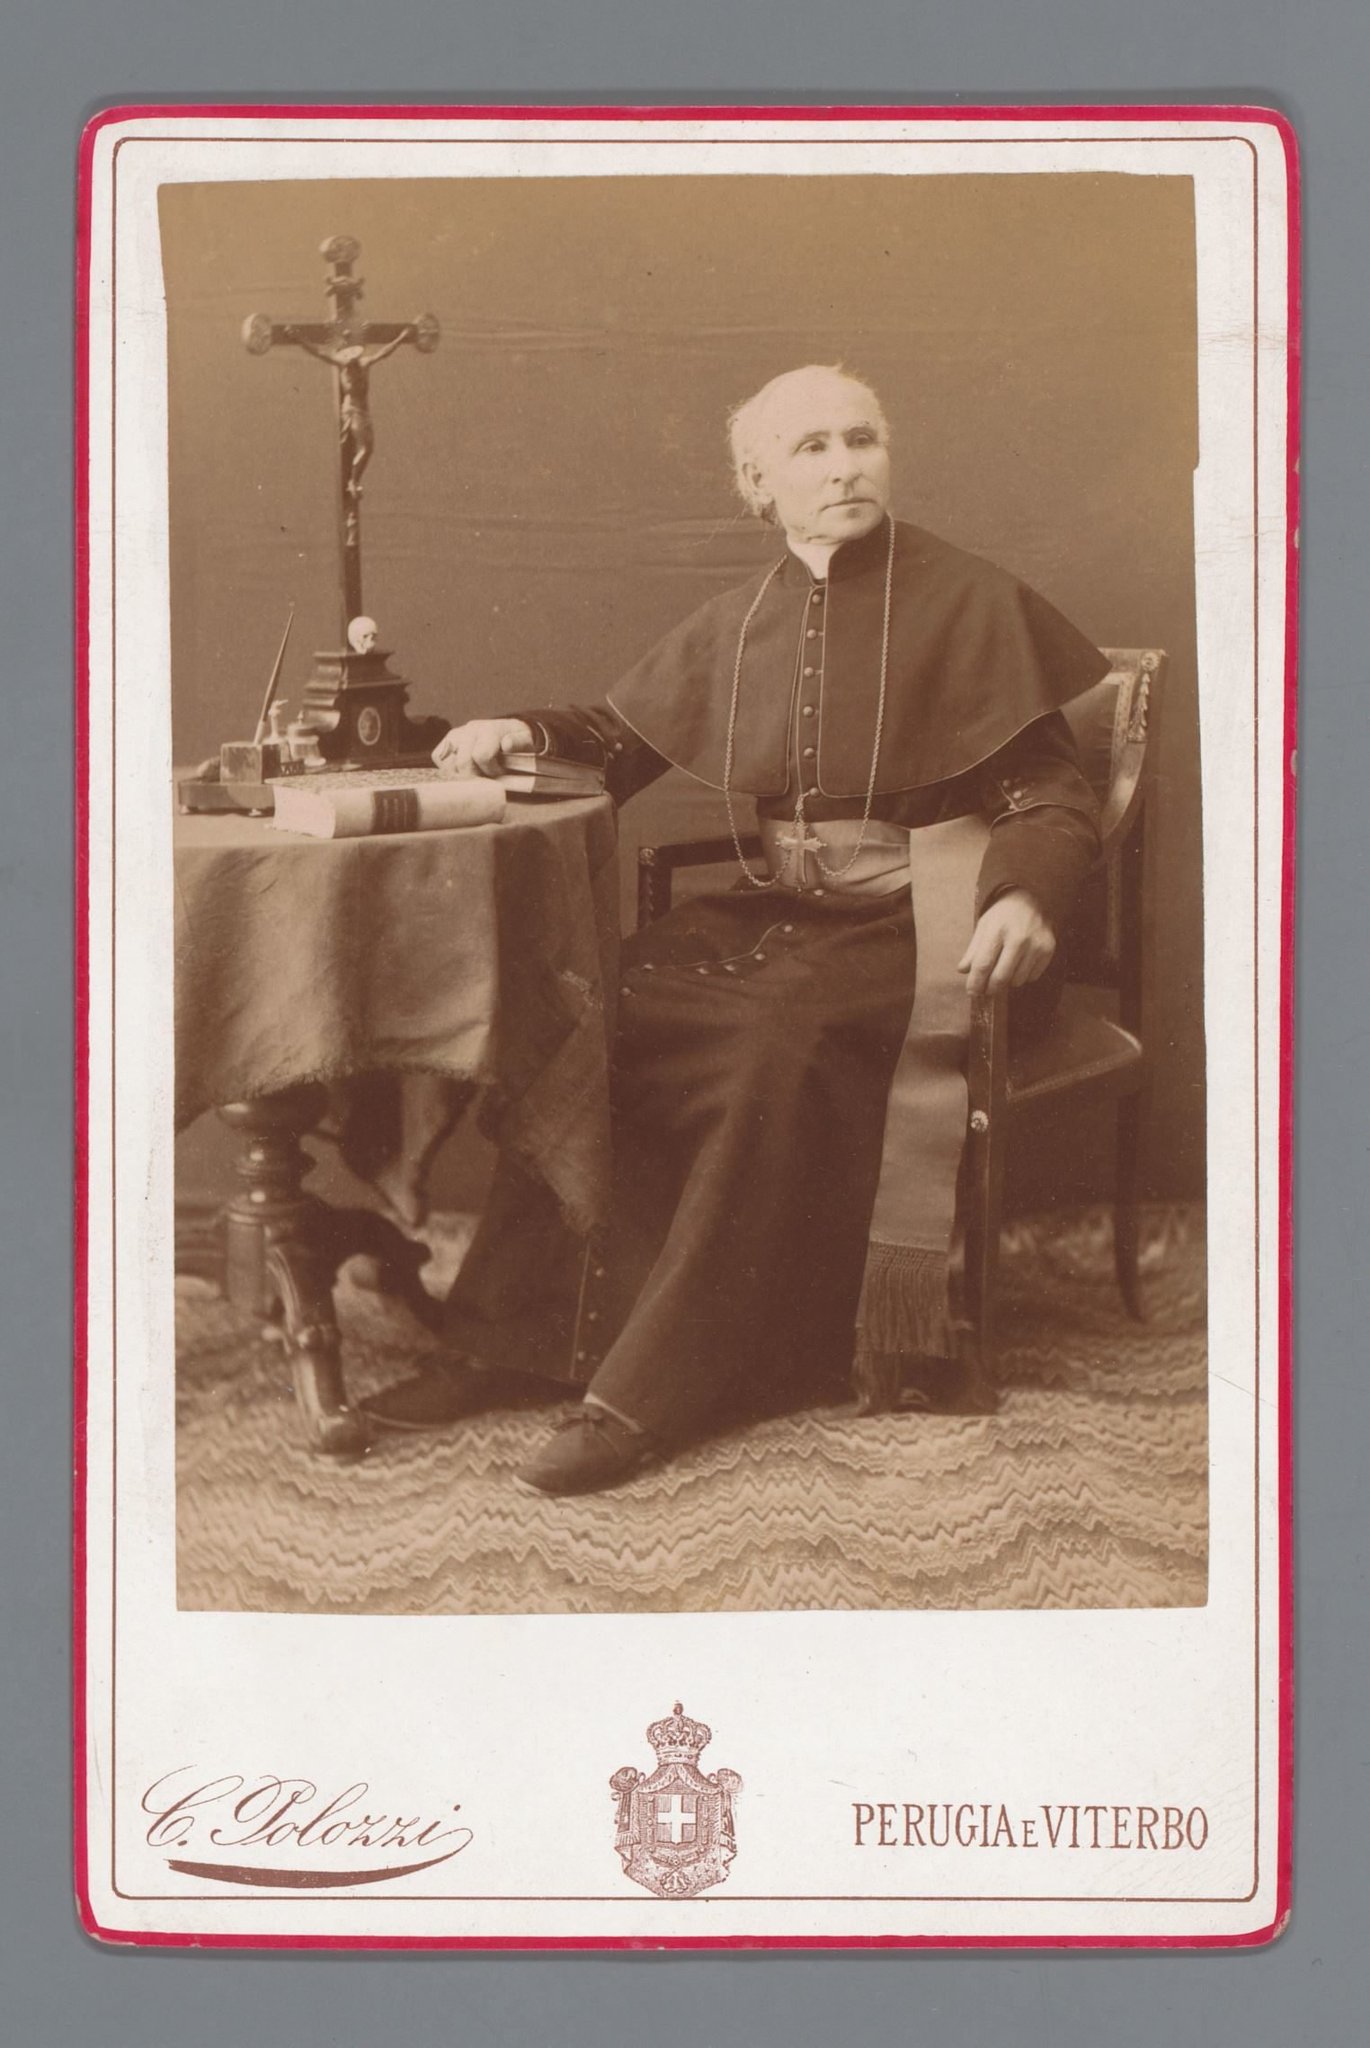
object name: cabinet photograph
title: Portret van monseigneur Briganti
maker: c. polozzi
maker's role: fotograaf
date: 1880-1900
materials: cardboard, photographic support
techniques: albumen print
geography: italy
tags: organization, functionaries and dignitaries in roman catholic church; clergy in general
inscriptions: inscription: ‘Monsignor Briganti’, inscription: ‘C. Polozzi Fotografo di S.M il re d'Italia Perugio e Viterbo’